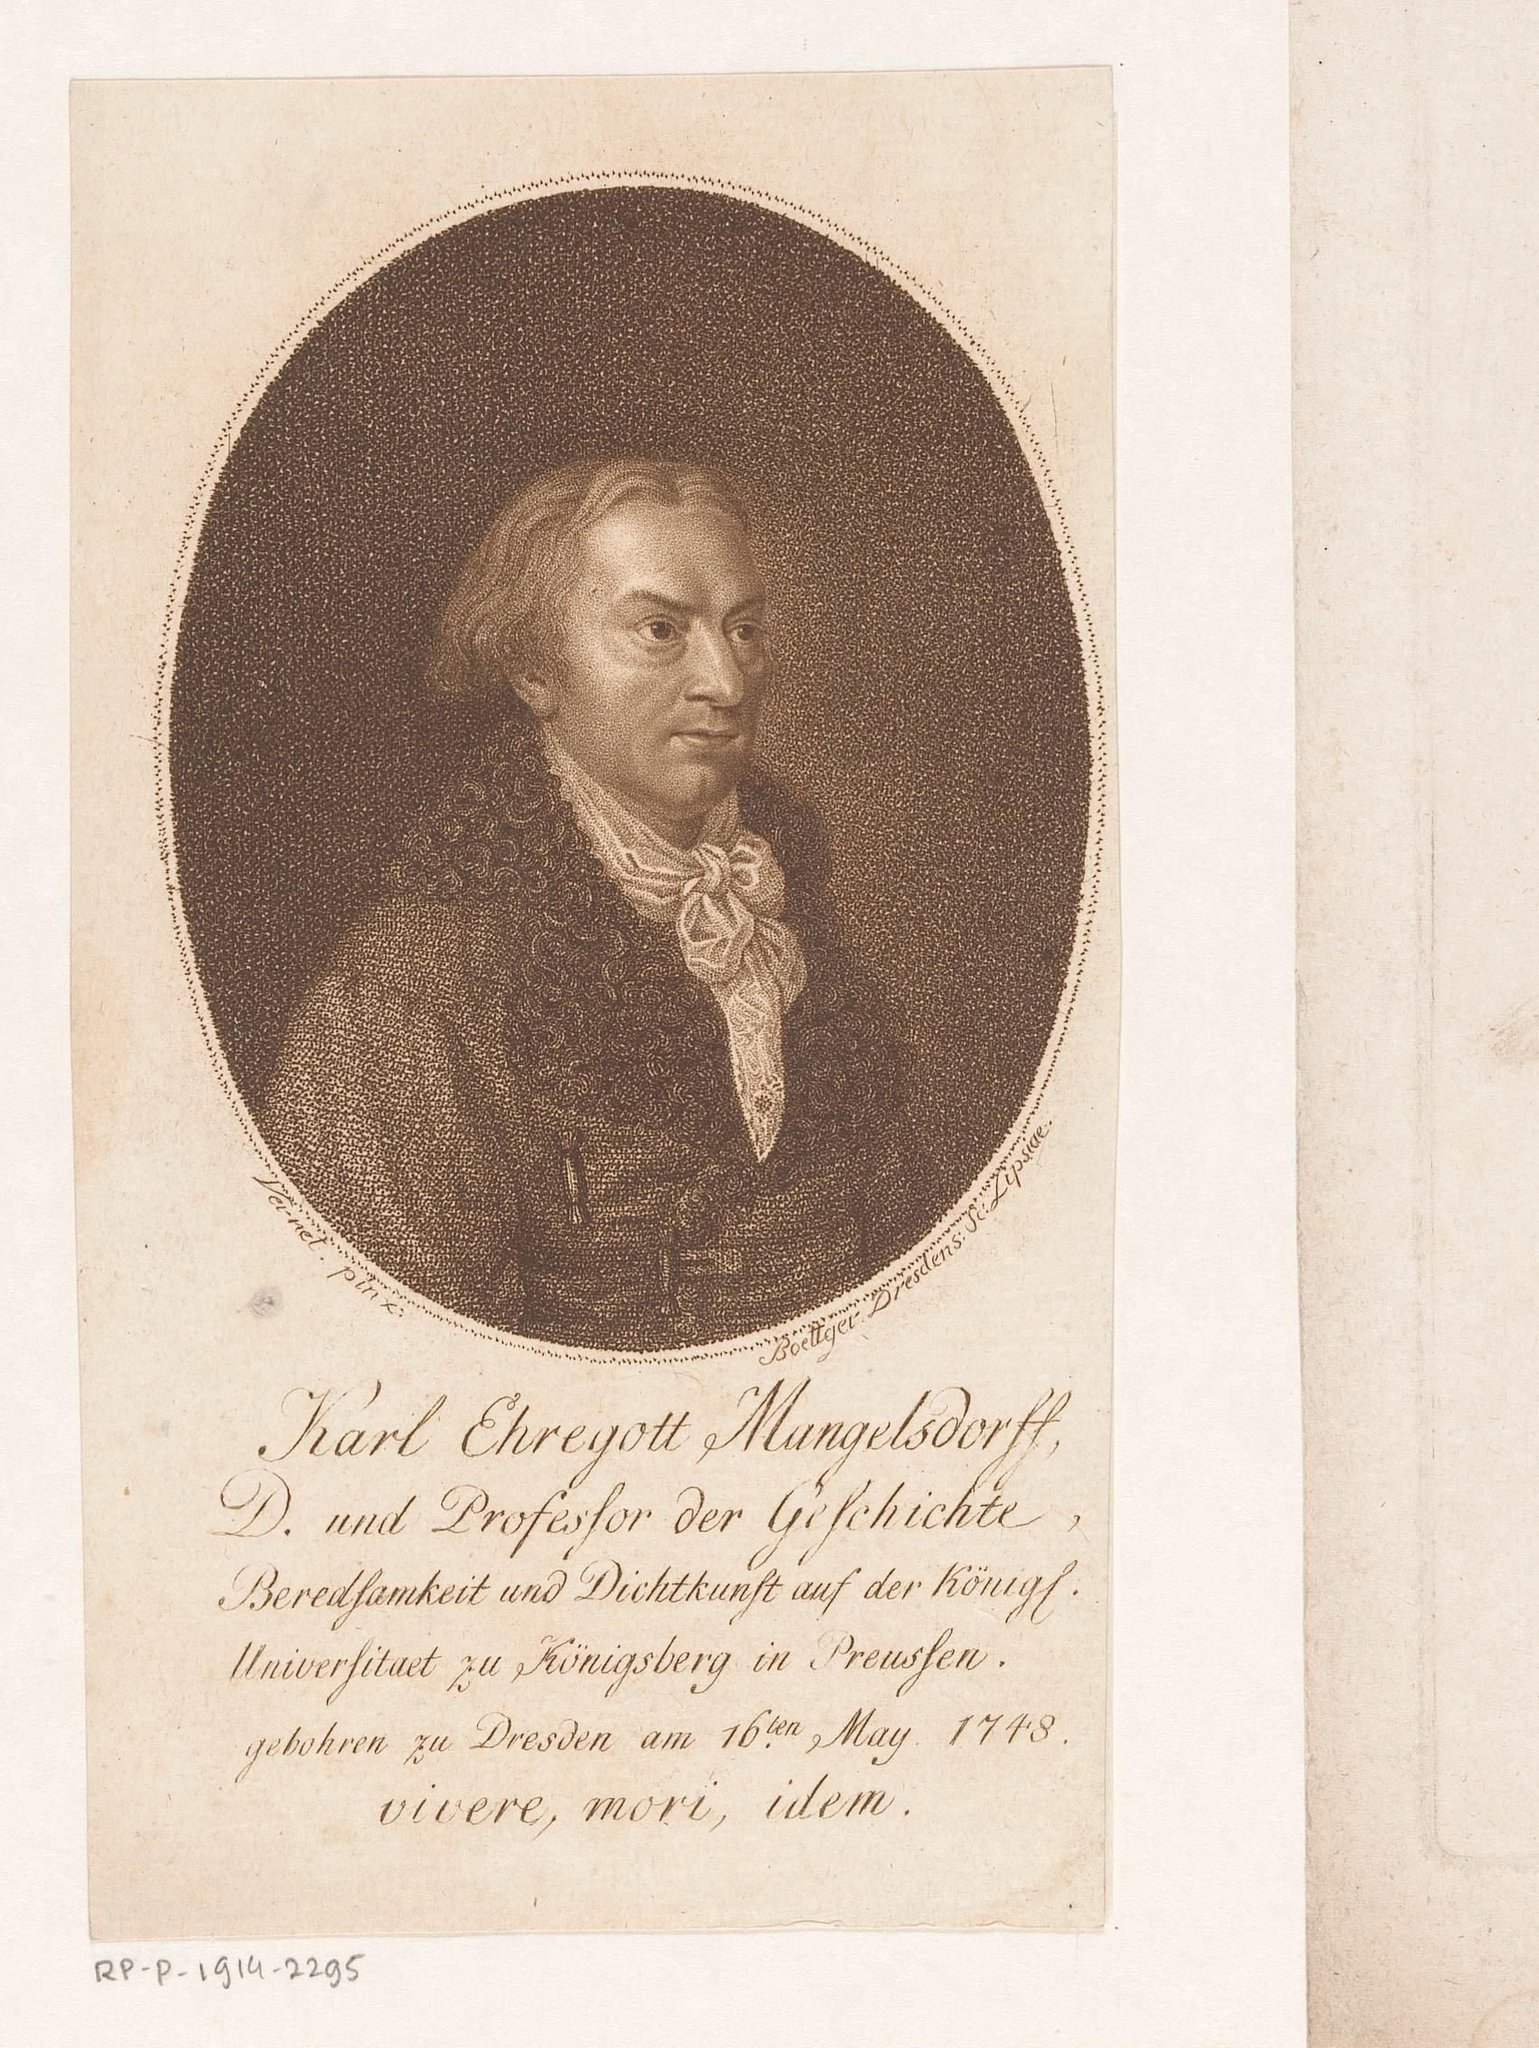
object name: print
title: Portret van Carl Ehregott Andreas Mangelsdorff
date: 1797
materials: paper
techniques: stippling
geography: leipzig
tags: historical persons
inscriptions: collector's mark: Lugt 2228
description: Prent ook gebruikt in: Mangelsdorff, Karl Ehregott. Hausbedarf aus der allgemeinen Geschichte der alten Welt, für seine Kinder und für Andere von zwölf bis funfzehn Jahren, allenfalls auch etwas darüber. dl. 5. Halle an der Saale en Leipzig: Johann Gottfried Ruff, 1797.